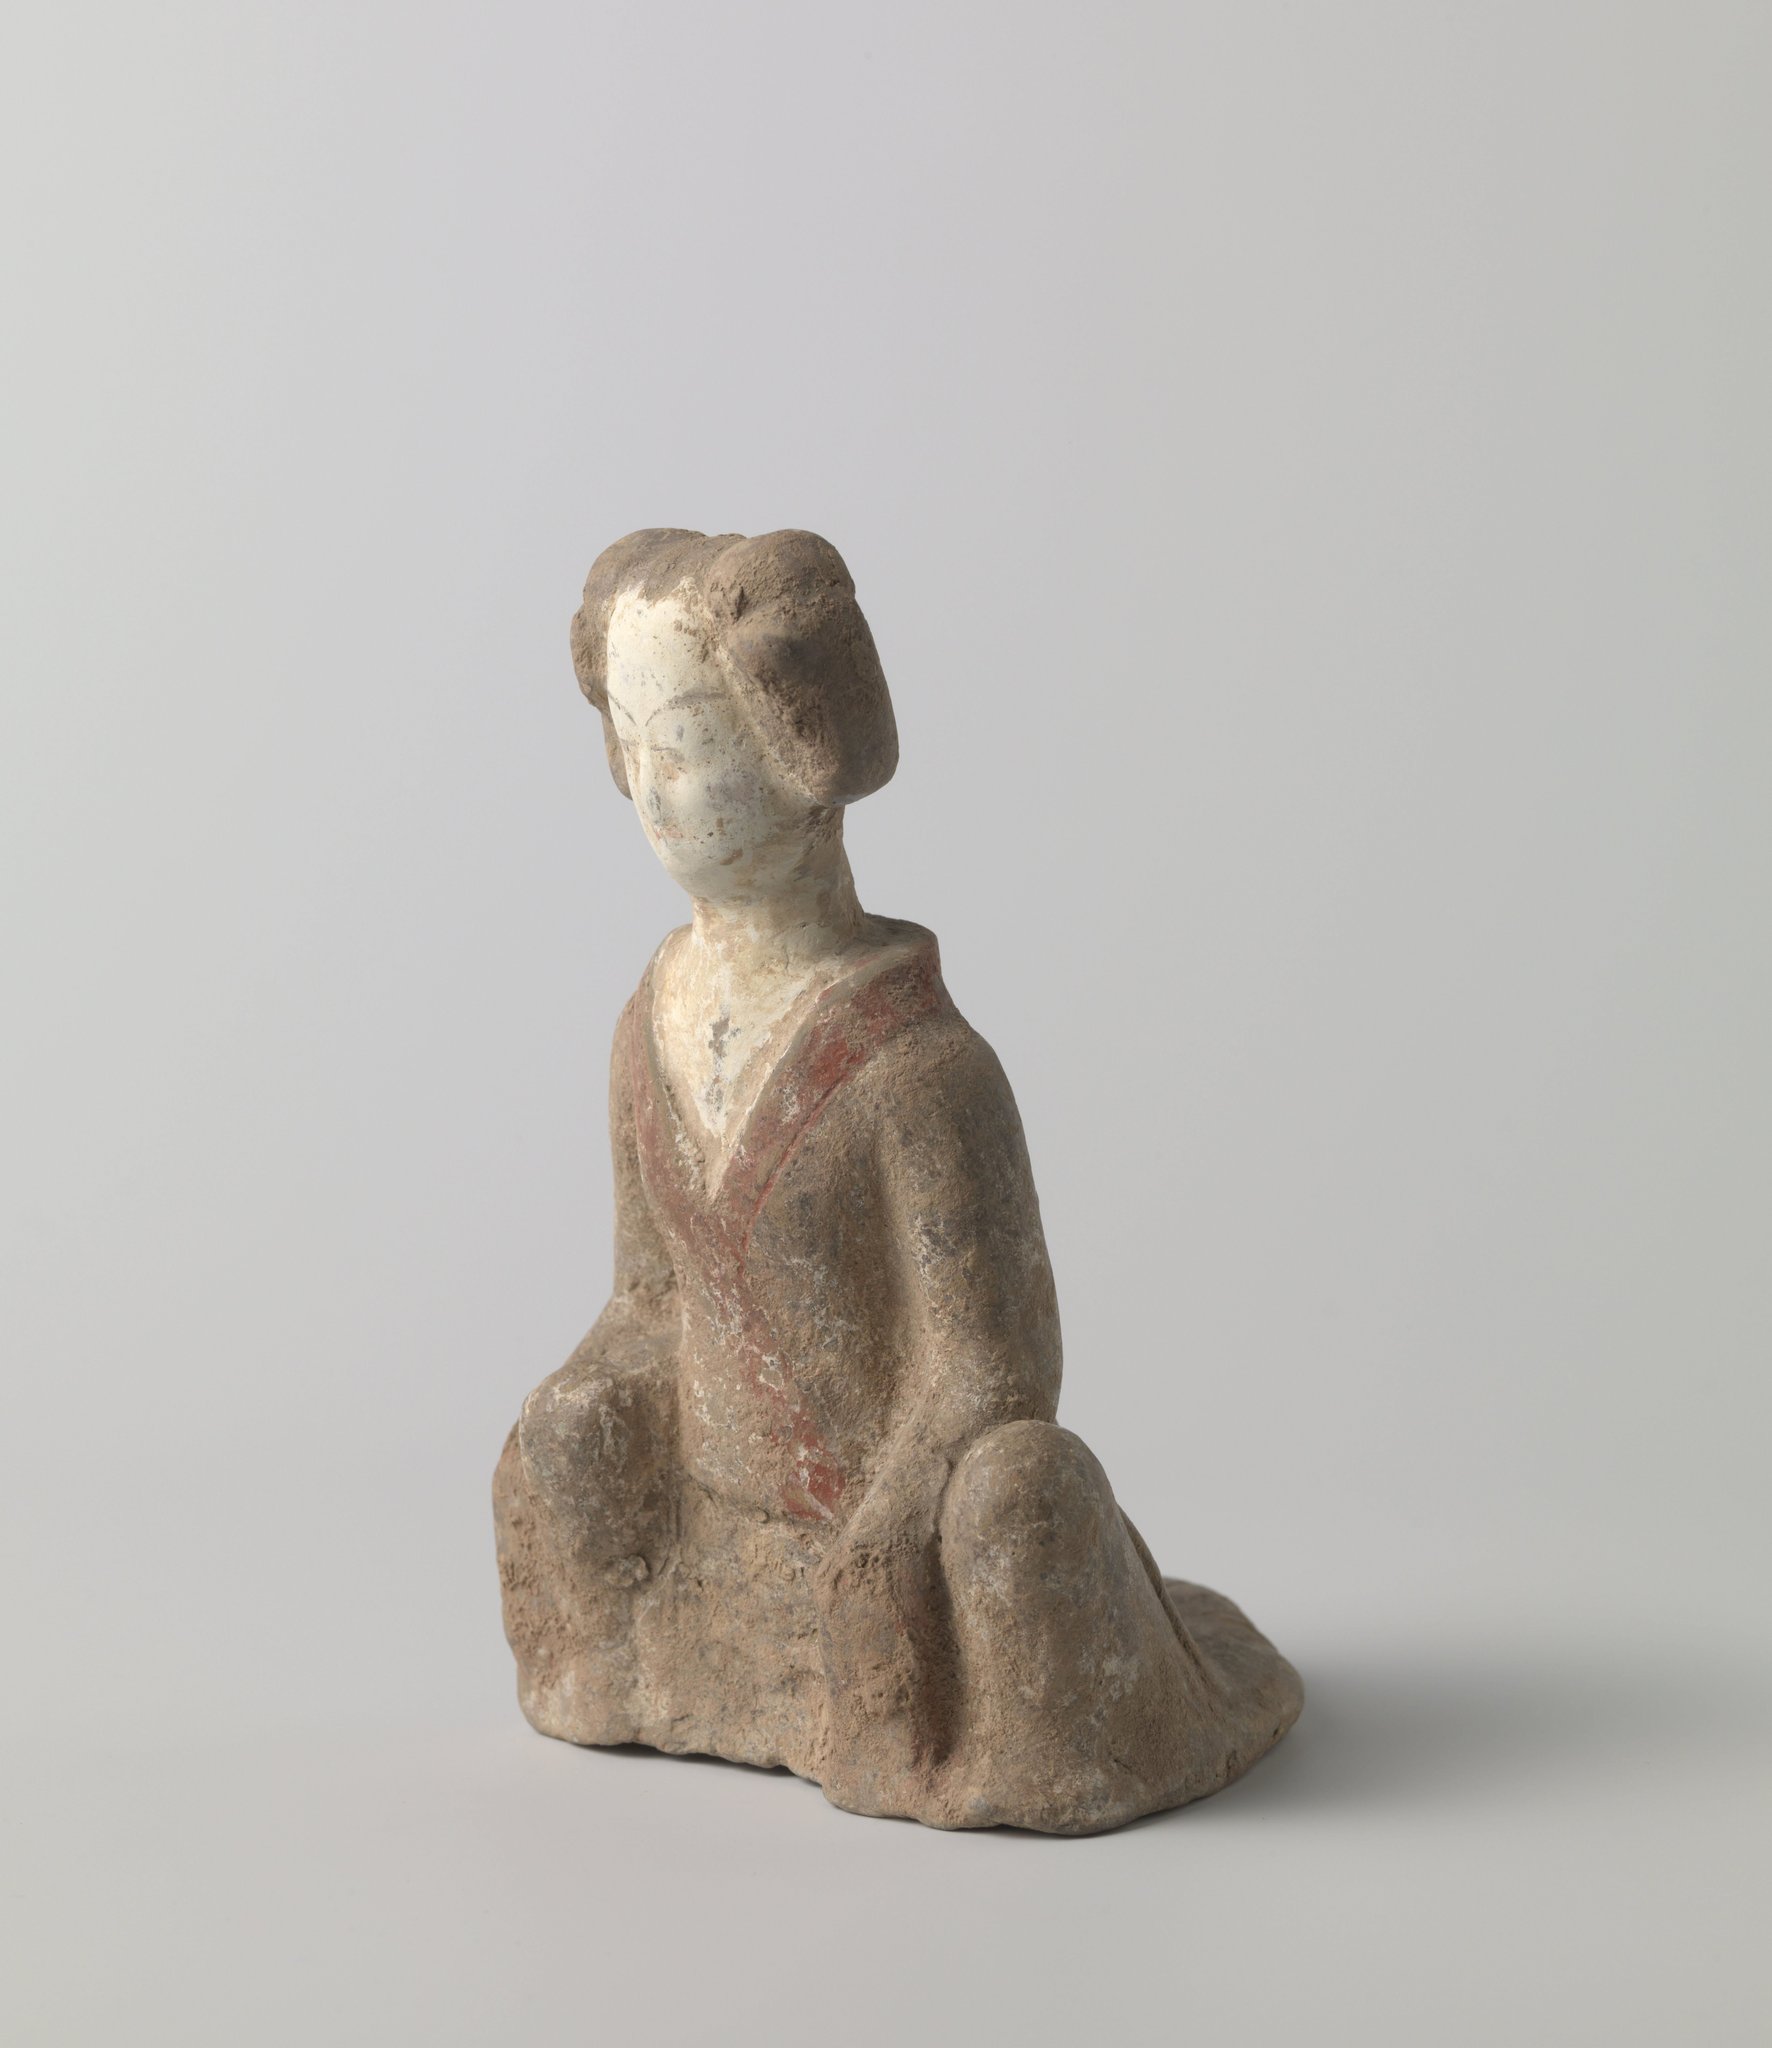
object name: figure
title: Tomb figure of a squatting woman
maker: Anonymous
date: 220-589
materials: earthenware, paint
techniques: firing, turning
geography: china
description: Squatting woman. Tomb figure. China, Northern and Southern Dynasties (265- 589), second half of the 5th - first half of the 6th century. Earthenware with polychromy. On loan from R. Flaes.